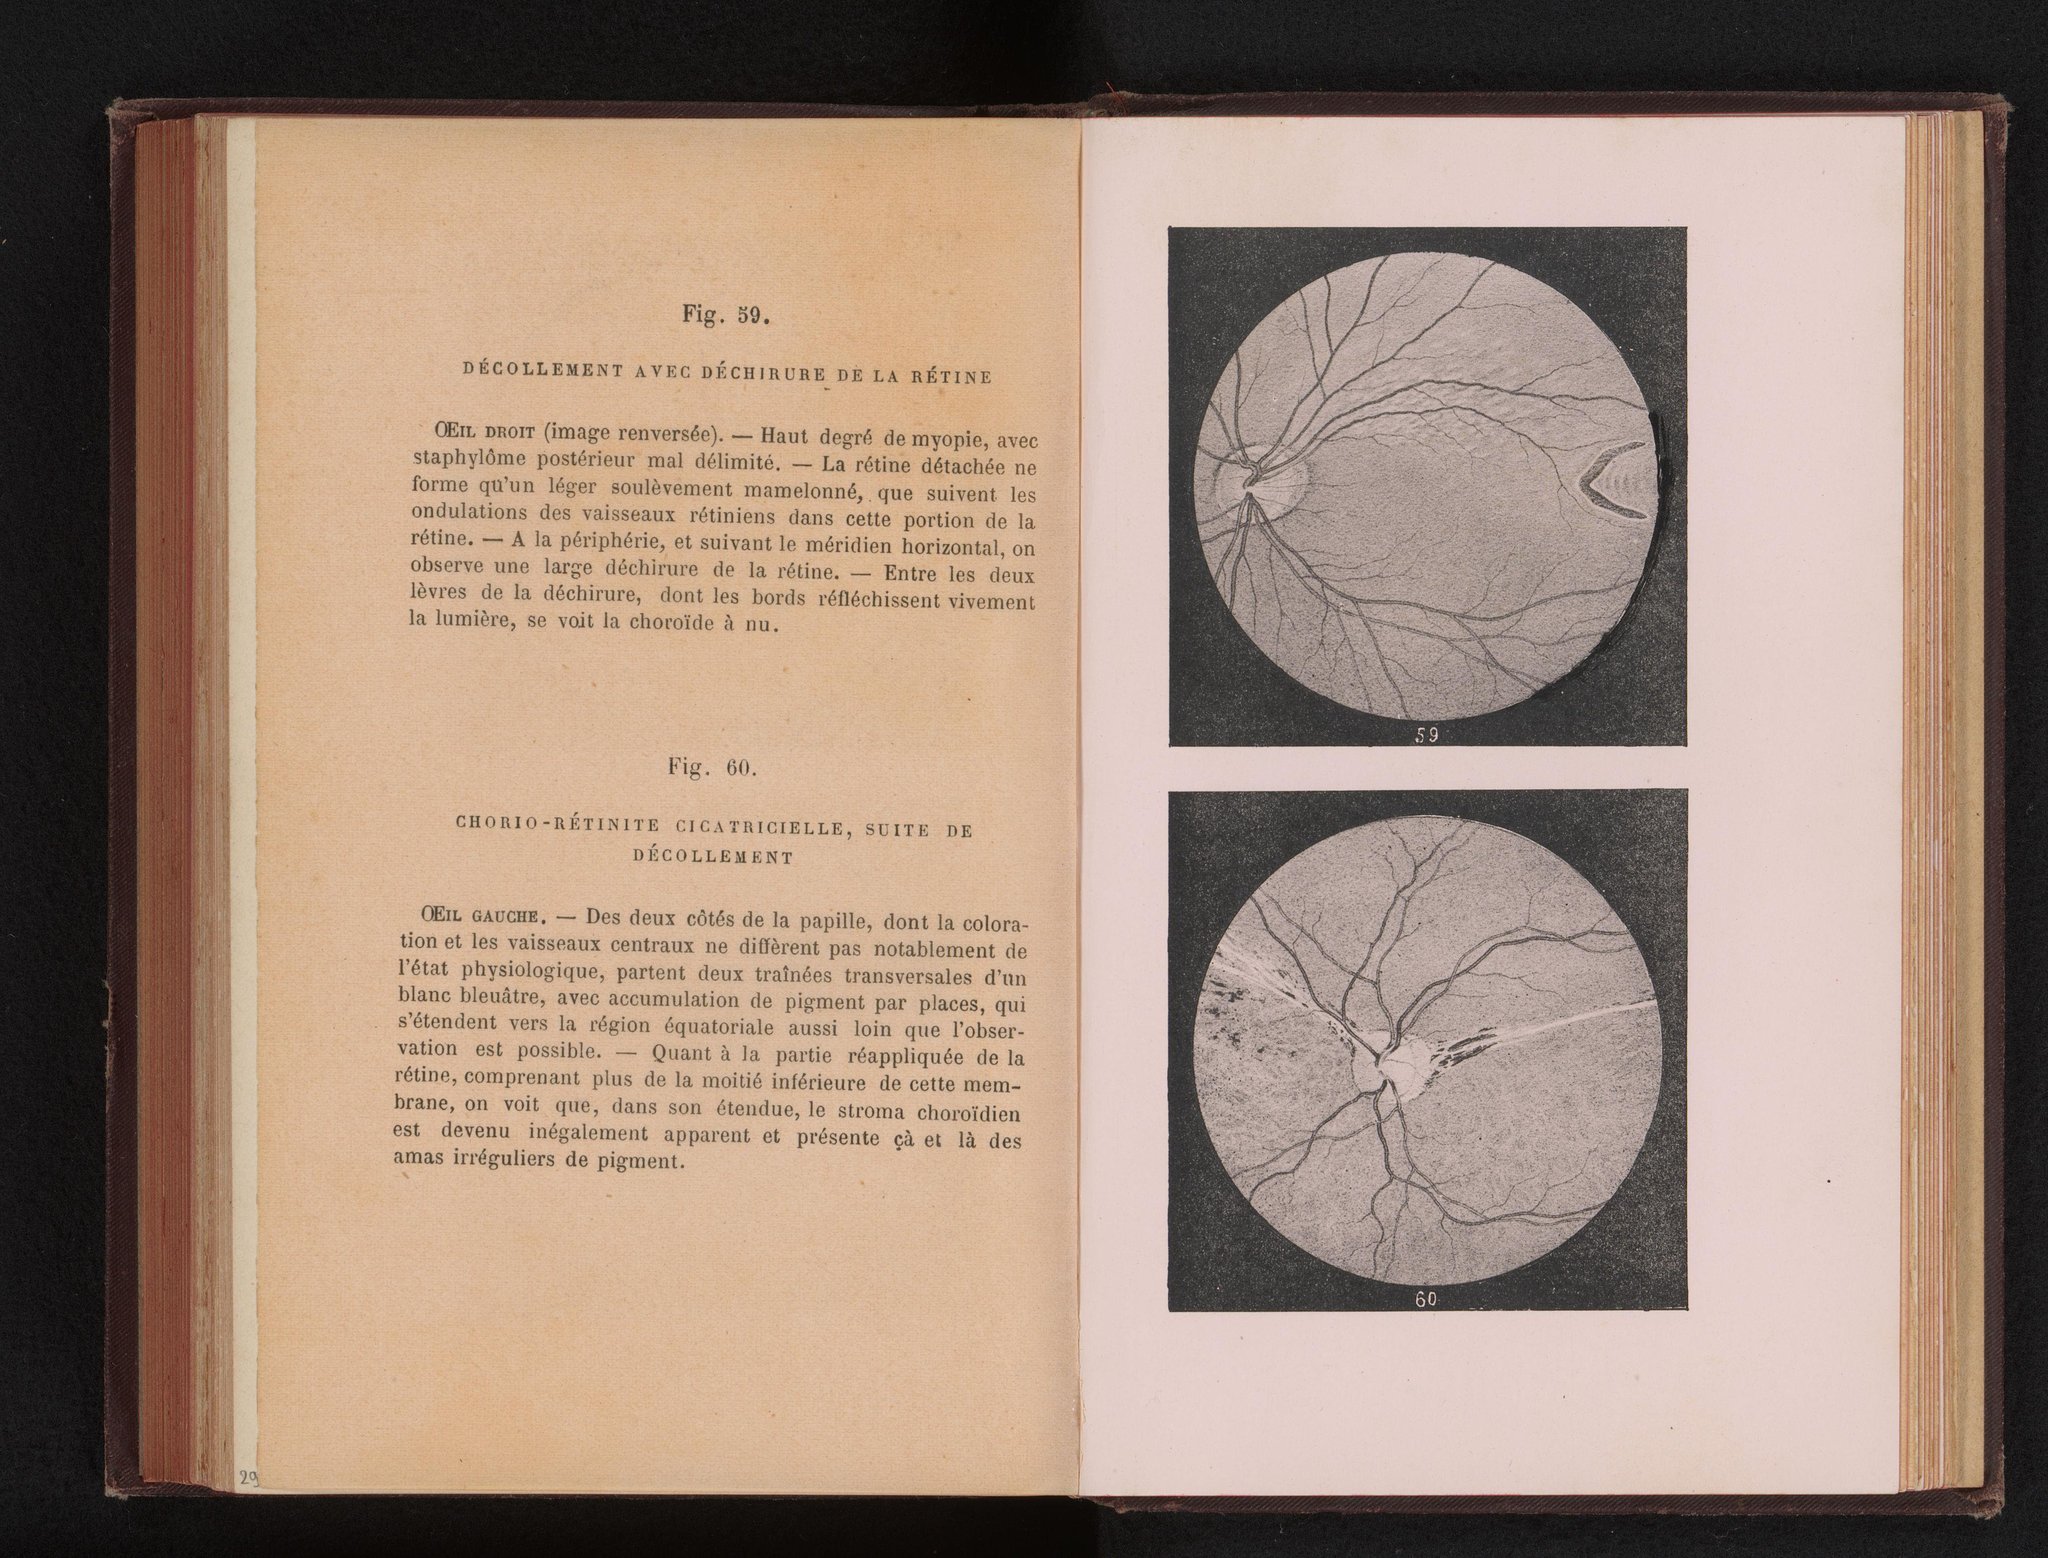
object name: reproduction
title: Fotoreproductie van twee anatomische tekeningen van het loslaten van het netvlies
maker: Anonymous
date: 1871-1891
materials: paper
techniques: photograph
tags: anatomy (non-medical), eyes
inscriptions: inscription: ‘Fig. 59. Décollement avec déchirure de la rétine Fig. 60. Chorio-rétinite cicatricielle, suite de décollement’